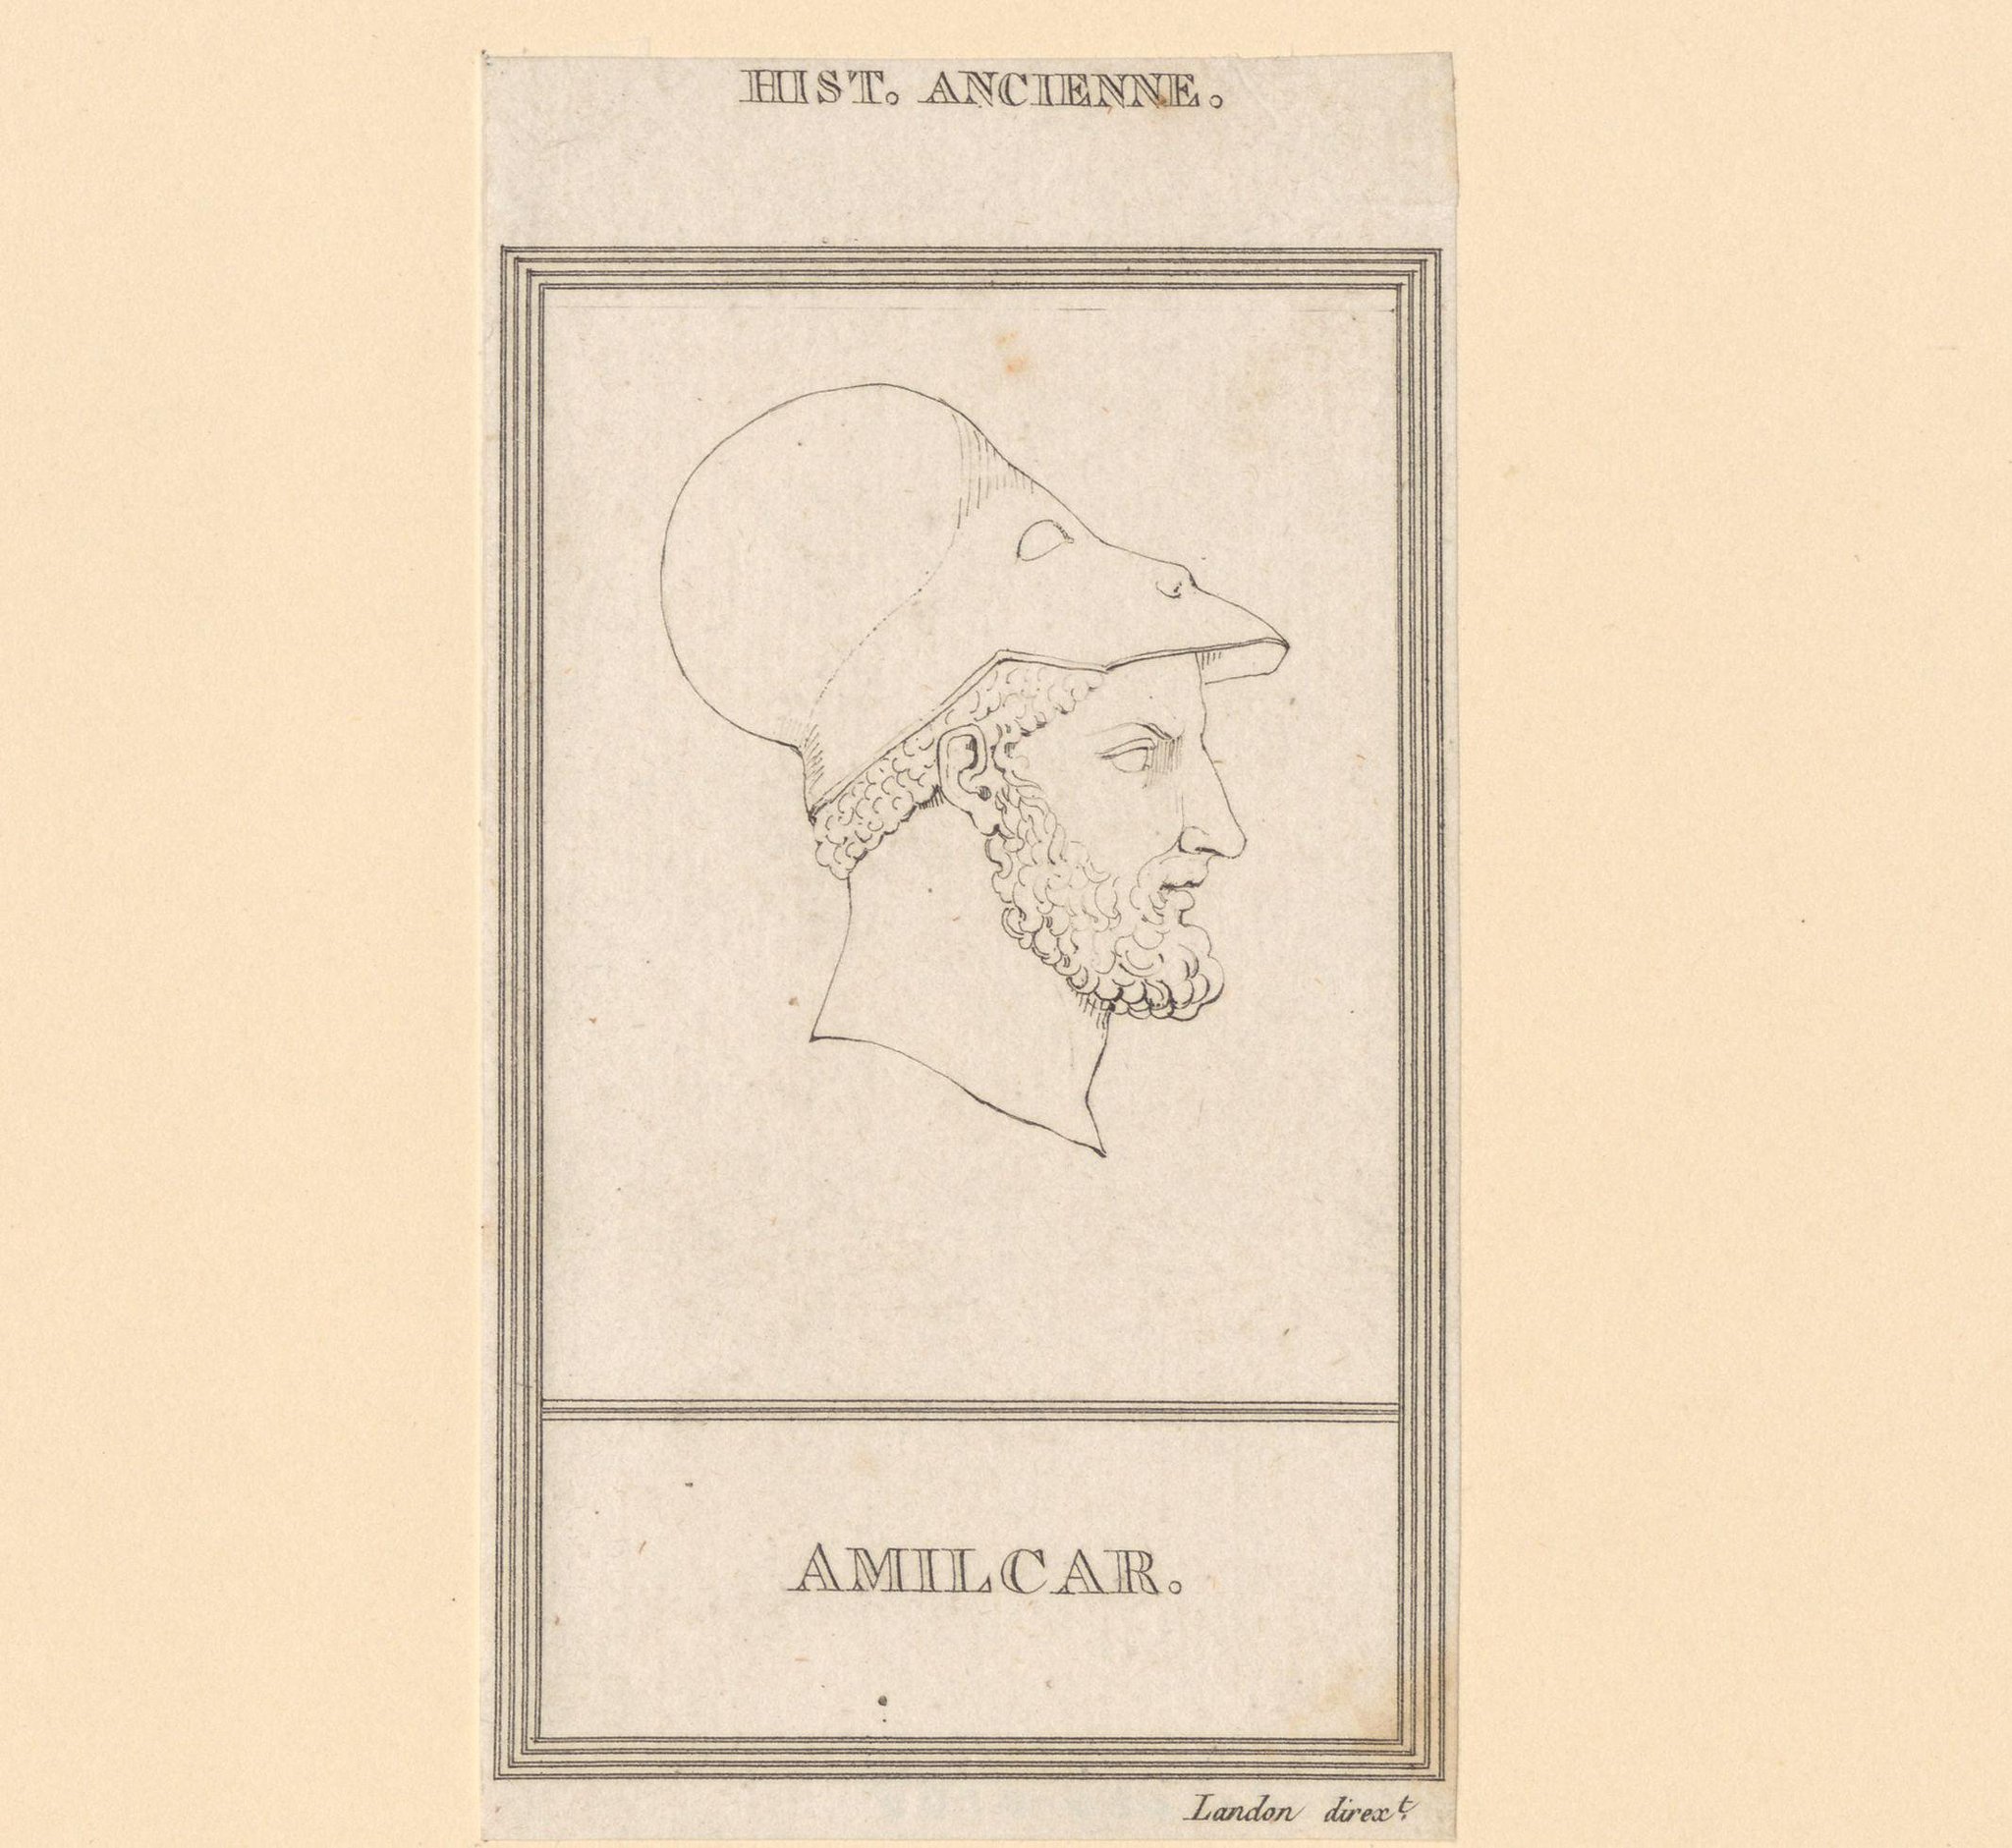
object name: book illustration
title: Portret van Hamilcar Barkas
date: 1805-1811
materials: paper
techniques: etching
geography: paris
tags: helmet, commander-in-chief, general, marshal, historical persons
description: Prent uit: Galerie historique des hommes les plus célèbres (...). Parijs: Charles Paul Landon, 1805-1811.